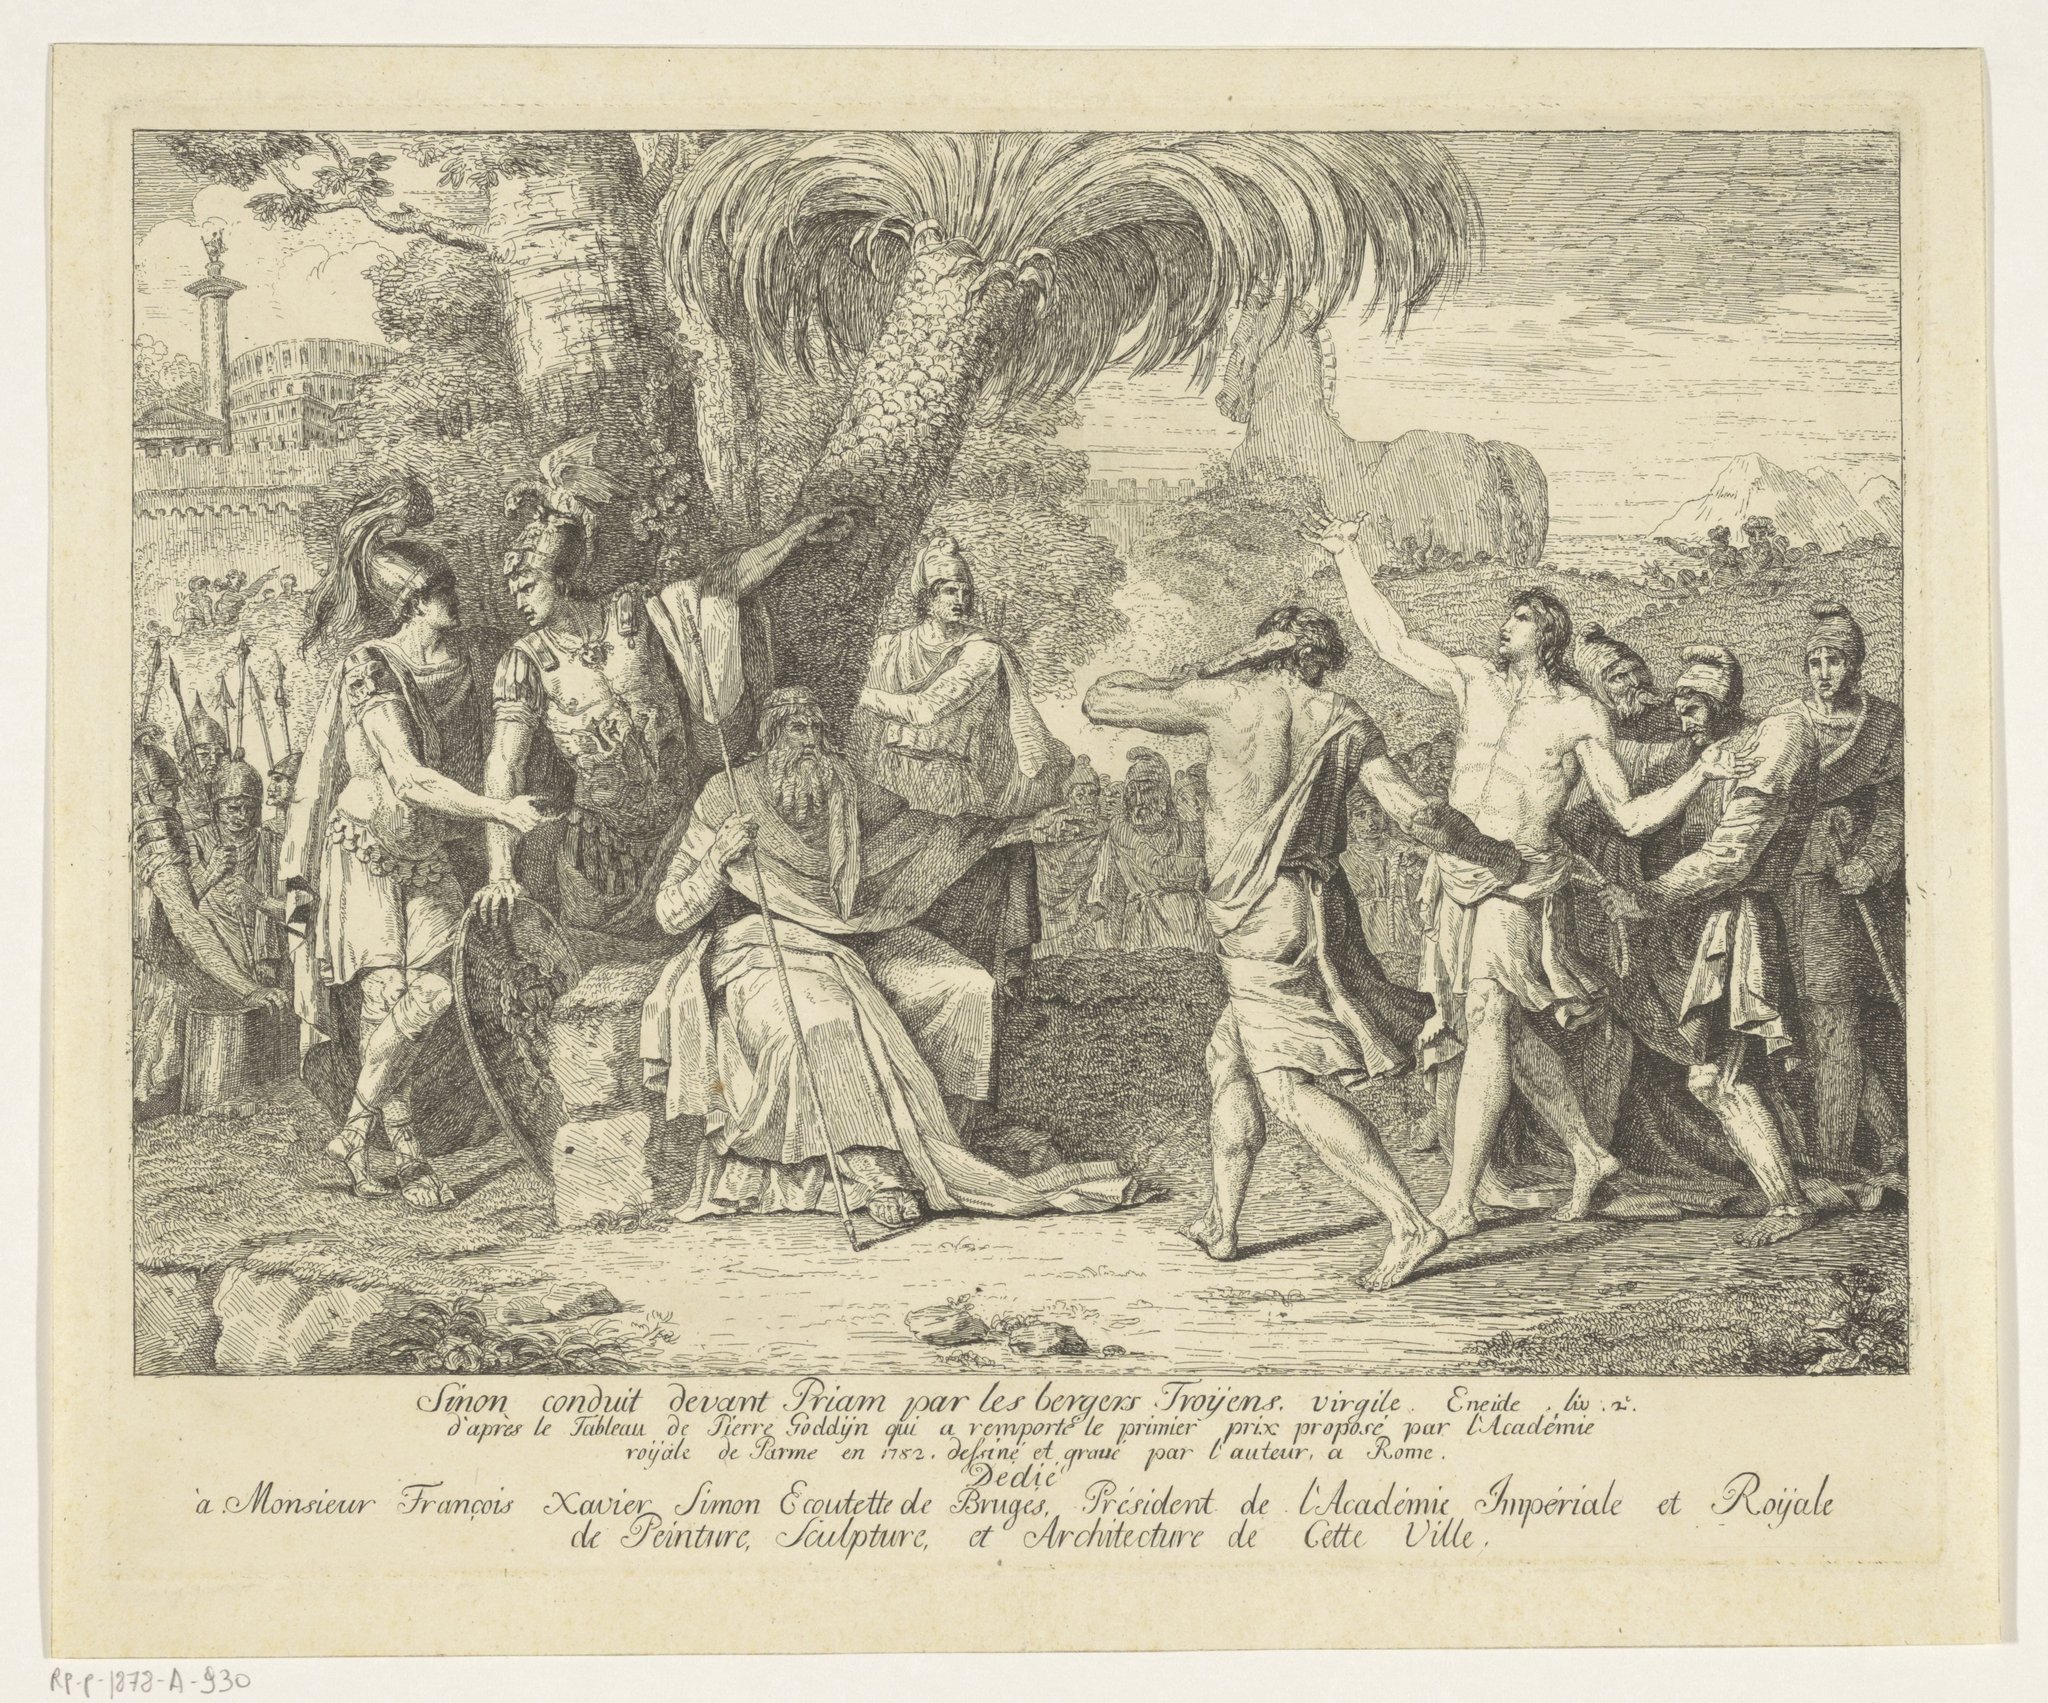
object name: print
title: Sinon voor Priamus gebracht.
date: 1782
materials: paper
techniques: etching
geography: rome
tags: sinon, a greek pretending to be a deserter, is brought in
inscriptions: collector's mark: Lugt 514, collector's mark: Lugt 2228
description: Koning Priamus zit onder een paar bomen, zijn scepter in de rechterhand. Twee generaals naast hem. Rechts wordt Sinon door vier herders naar de koninig gevoerd. Op de achtergrond het Trojaanse paard voor de stad Troje. In het marge een Frans onderschrift.